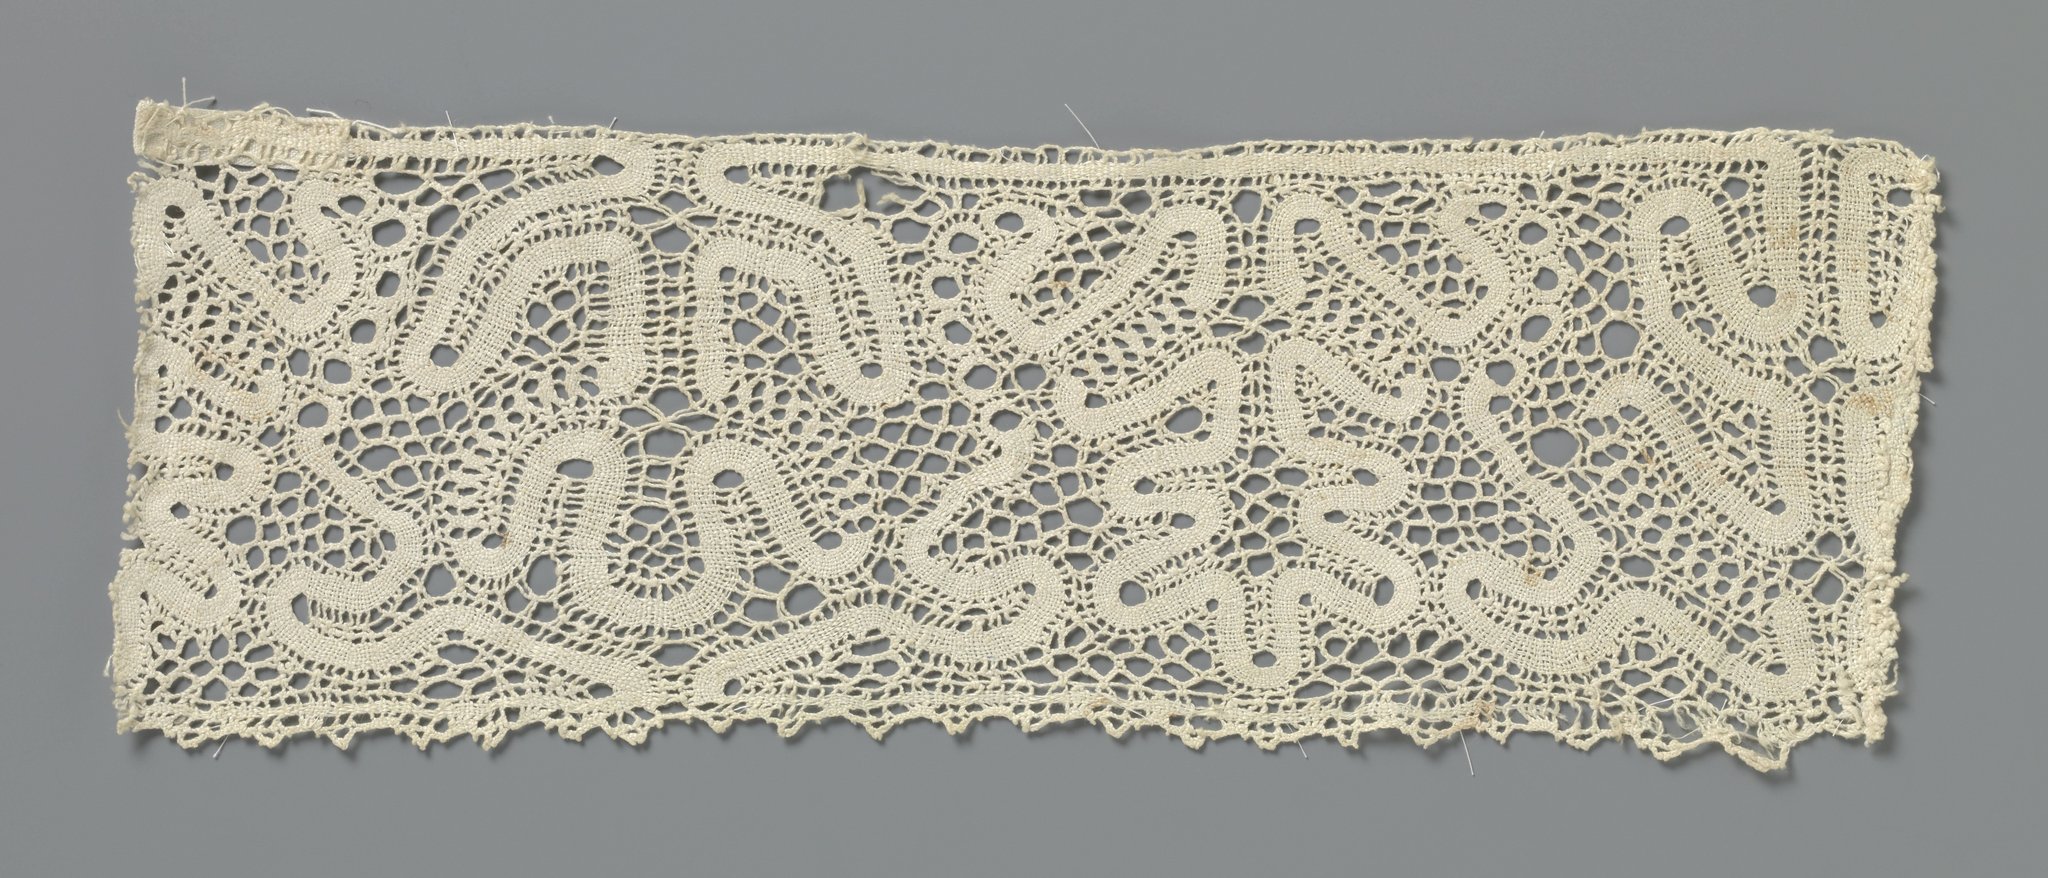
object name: strip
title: Strook kloskant met gestileerde symmetrische bloemen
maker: Anonymous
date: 1800-1899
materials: linen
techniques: lace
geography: abruzzo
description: Strook naturelkleurige kloskant, Oosteuropese kant. Het patroon bestaat uit twee gestileerde symmetrische bloemen, waarbij de contouren zijn gemaakt met kronkelende linten, die minimaal in breedte variëren. De ene bloem heeft een kelk met drie lobben en zou een tulp kunnen voorstellen. De andere is een palmetbloem heeft vijf lobben. Beide bloemen hangen vanuit de bovenzijde van de strook naar beneden, tot bijna aan de onderzijde. De motieven zijn met elkaar verbonden door een variatie aan maasgronden. De linten zijn gemaakt in linnenslag met opengewerkte randjes. De bovenzijde is afgewerkt met een recht geklost lint in linnenslag met aan beide zijden opengewerkte randjes. De onderzijde is afgewerkt met een schulpenrand waarbij de schulpjes zijn gemaakt met vlechtjes.